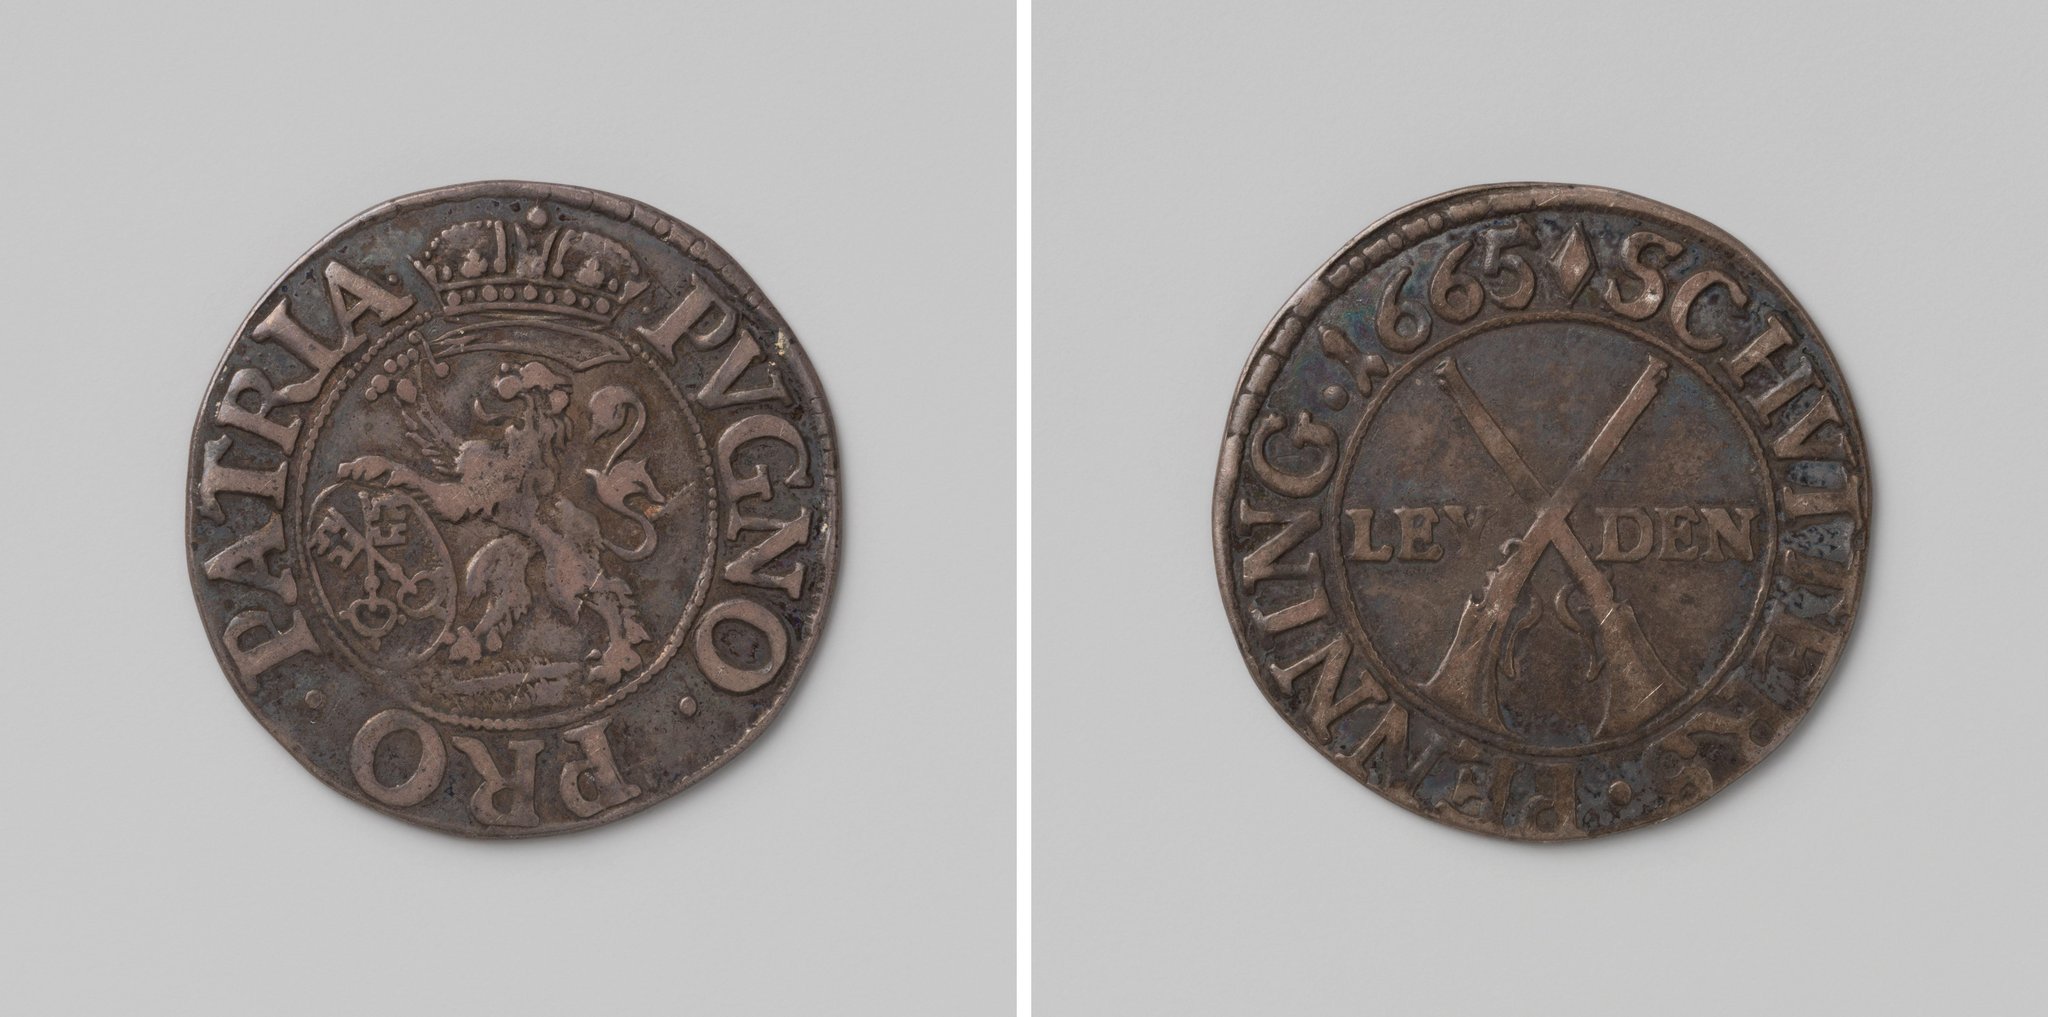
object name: marksman medal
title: Schutterij van Leiden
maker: Anonymous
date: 1665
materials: silver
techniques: striking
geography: leiden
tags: leiden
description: Zilveren penning. Voorzijde: leeuw met zwaard in boven hoofd geheven rechterklauw en schild in linkerklauw onder kroon binnen omschrift. Keerzijde: twee gekruiste musketten tussen opschrift binnen omschrift